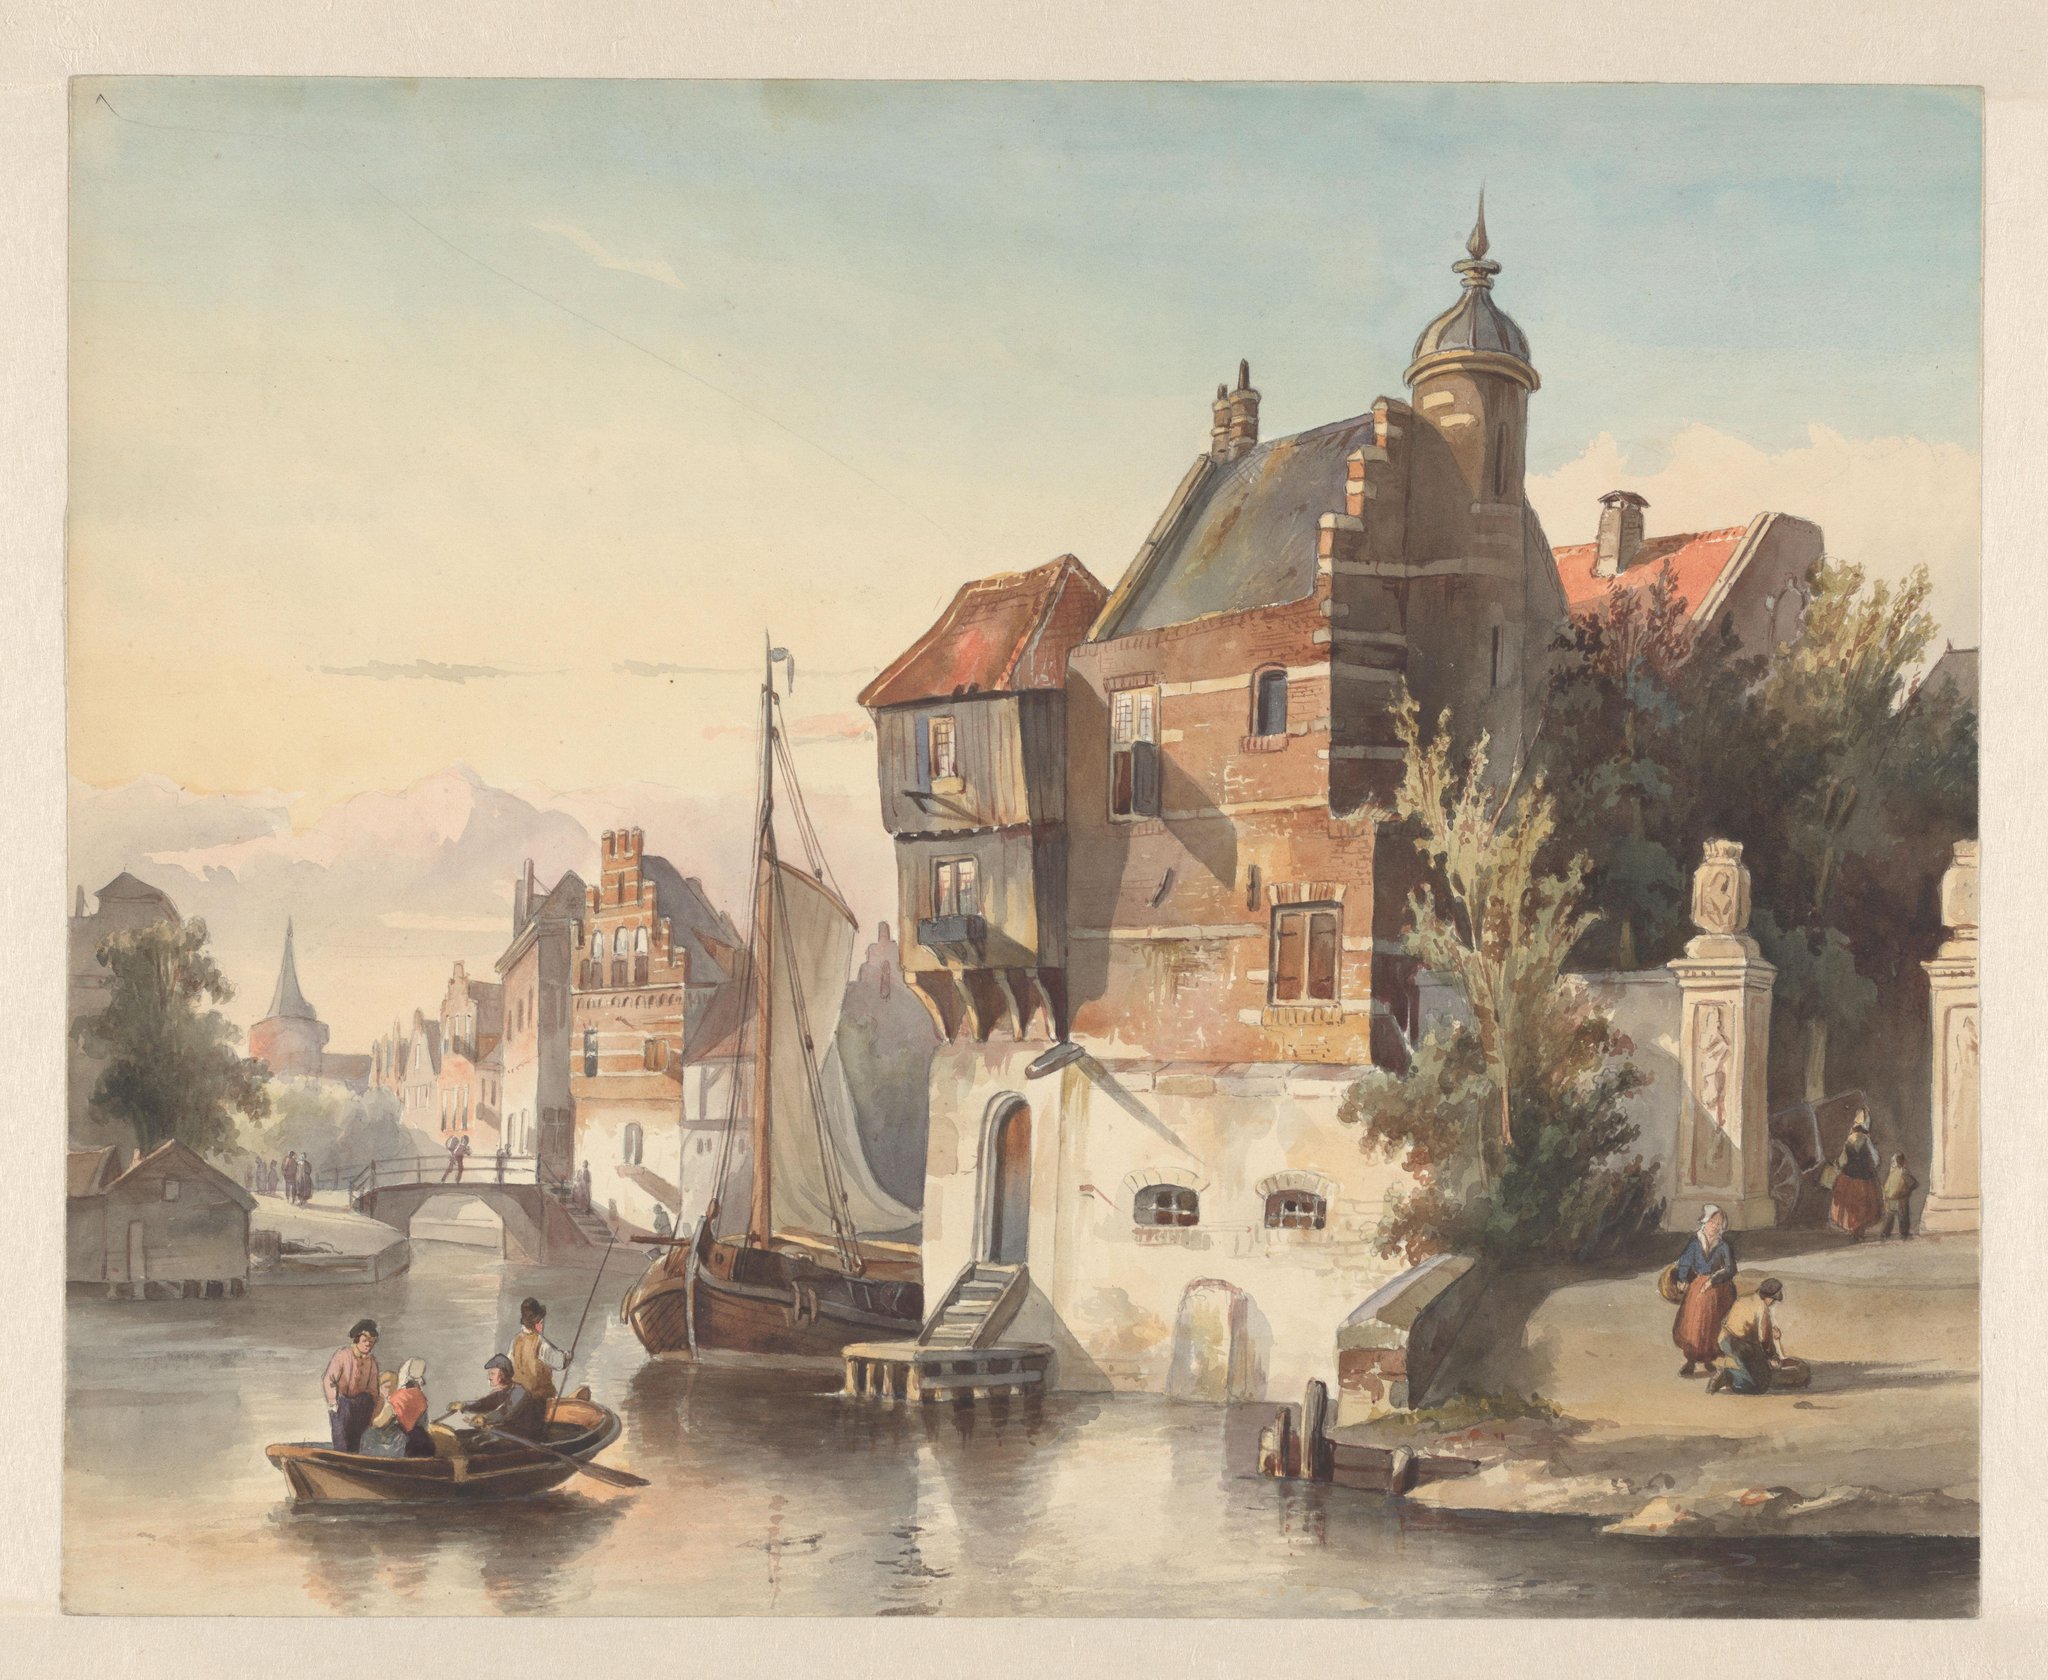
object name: drawing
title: Stadsgezicht met gracht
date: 1840-1860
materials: paper, pencil, watercolor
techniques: brush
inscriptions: annotation: ‘Doekraam 48 1/2 bij 39 Ned. Duimen’, number: ‘00:502’